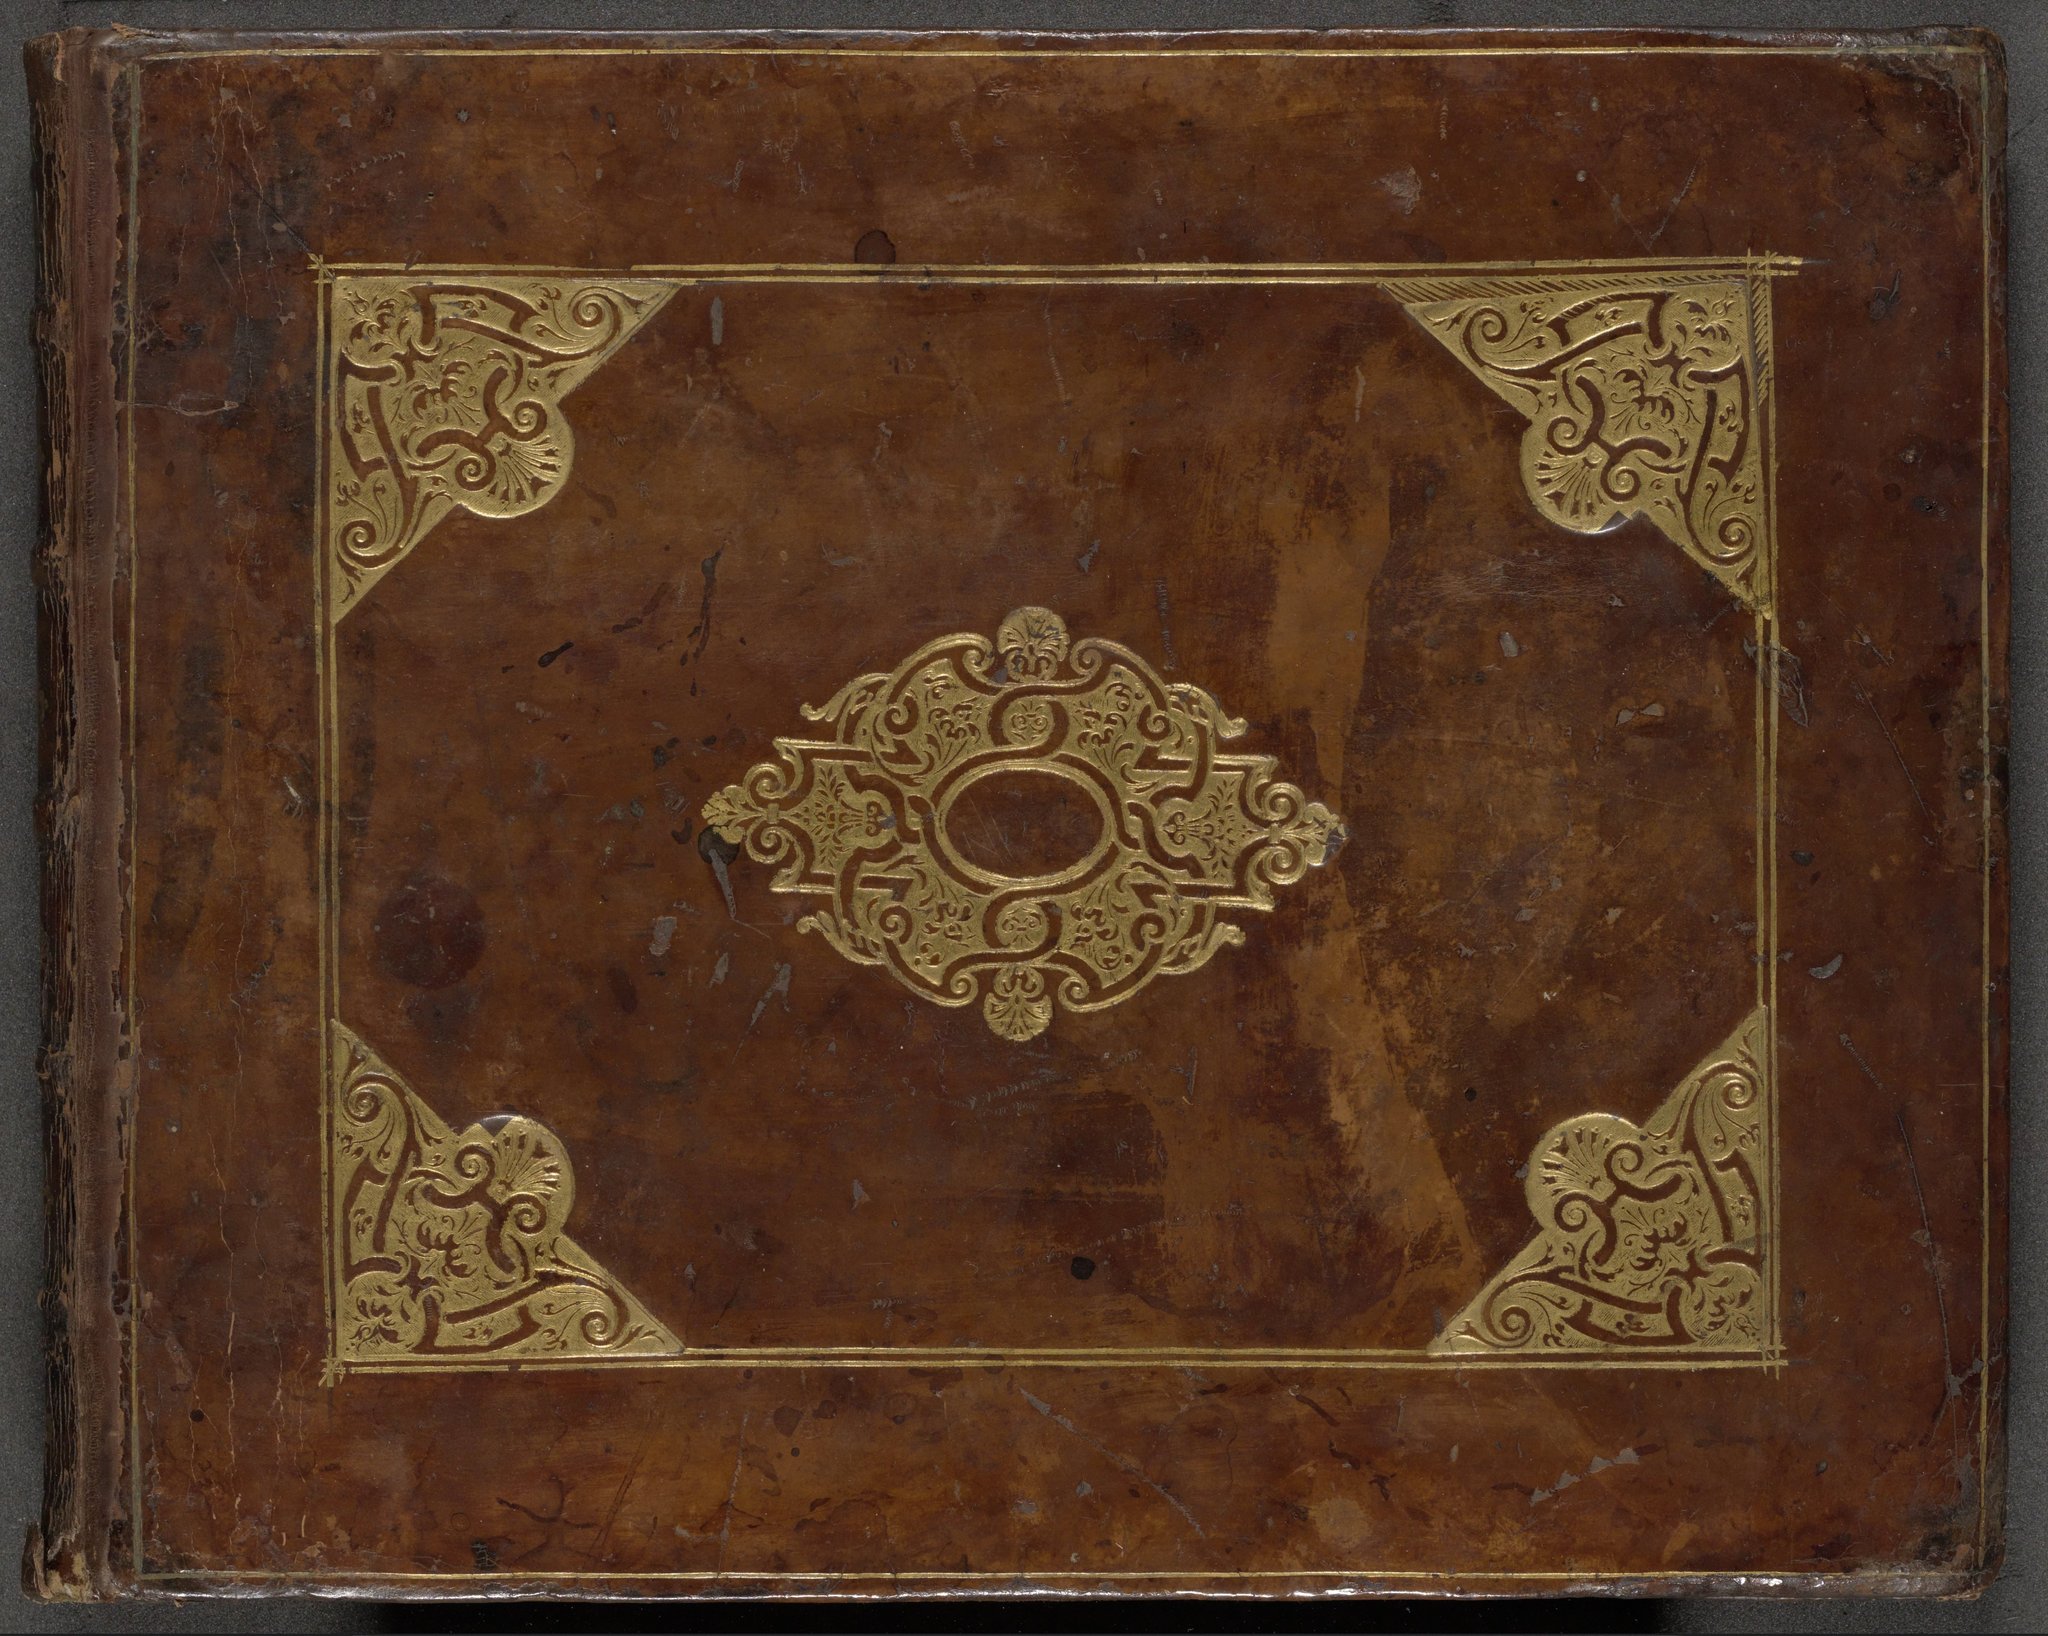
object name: prentrecueil, prentenalbum, prentalbum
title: Prentbijbel met voorstellingen uit het Oude Testament, Deel 1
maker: gerard de jode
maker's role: draughtsman, print maker, publisher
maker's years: 1508-1591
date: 1579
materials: leather, paper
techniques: bookbinding, printing, engraving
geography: antwerp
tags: old testament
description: Een aantal series is niet compleet: - De prent met de titel Noach gaat met zijn familie en de dieren aan boord van de ark (nr. 2) naar Hans Bol uit de serie Geschiedenis van Noach ontbreekt. - Het originele albumblad met de prent van de Besnijdenis van Sichem in de serie Geschiedenis van Dina en Sichem lijkt eens uit het album zijn verwijderd. De kim van het afgesneden blad is zichtbaar. - De prent met de titel Stamvaders Aser Naftali en de prent met de titel Stamvaders Jozef en Benjamin uit de serie De twaalf stamvaders van Israël ontbreken. - Het albumblad met de prent Juda geeft Chira de opdracht om de prostituee te zoeken in de serie Geschiedenis van Juda en Tamar lijkt uit het album zijn verwijderd. De kim van het afgesneden blad is zichtbaar. - De prent met de titel Besnijdenis van de Israëlieten (nr. 3) uit de serie Geschiedenis van Jozua ontbreekt. - De prent met de titel Boaz koopt het land van Ruth en Naomi uit de serie Geschiedenis van Ruth ontbreekt. De objectnummers RP-P-1995-25-53 en RP-P-1995-25-54 zijn per abuis overgeslagen bij het nummeren van de prenten en bestaan niet.